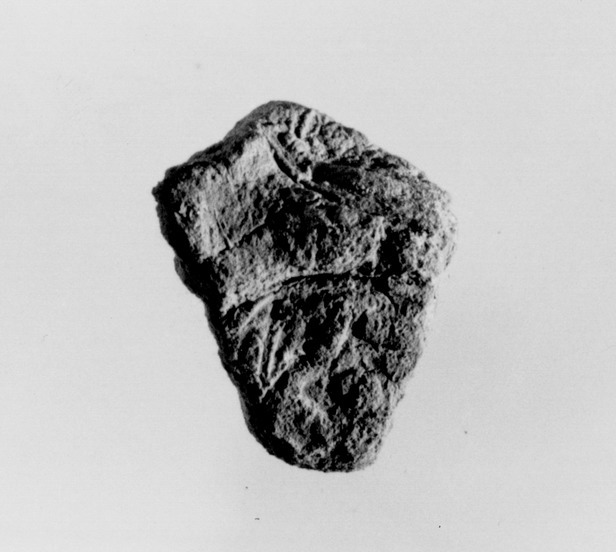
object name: sealing, upper egypt, lower egypt, amun re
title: Document Sealing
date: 1390-1352 BCE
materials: mud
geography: egypt